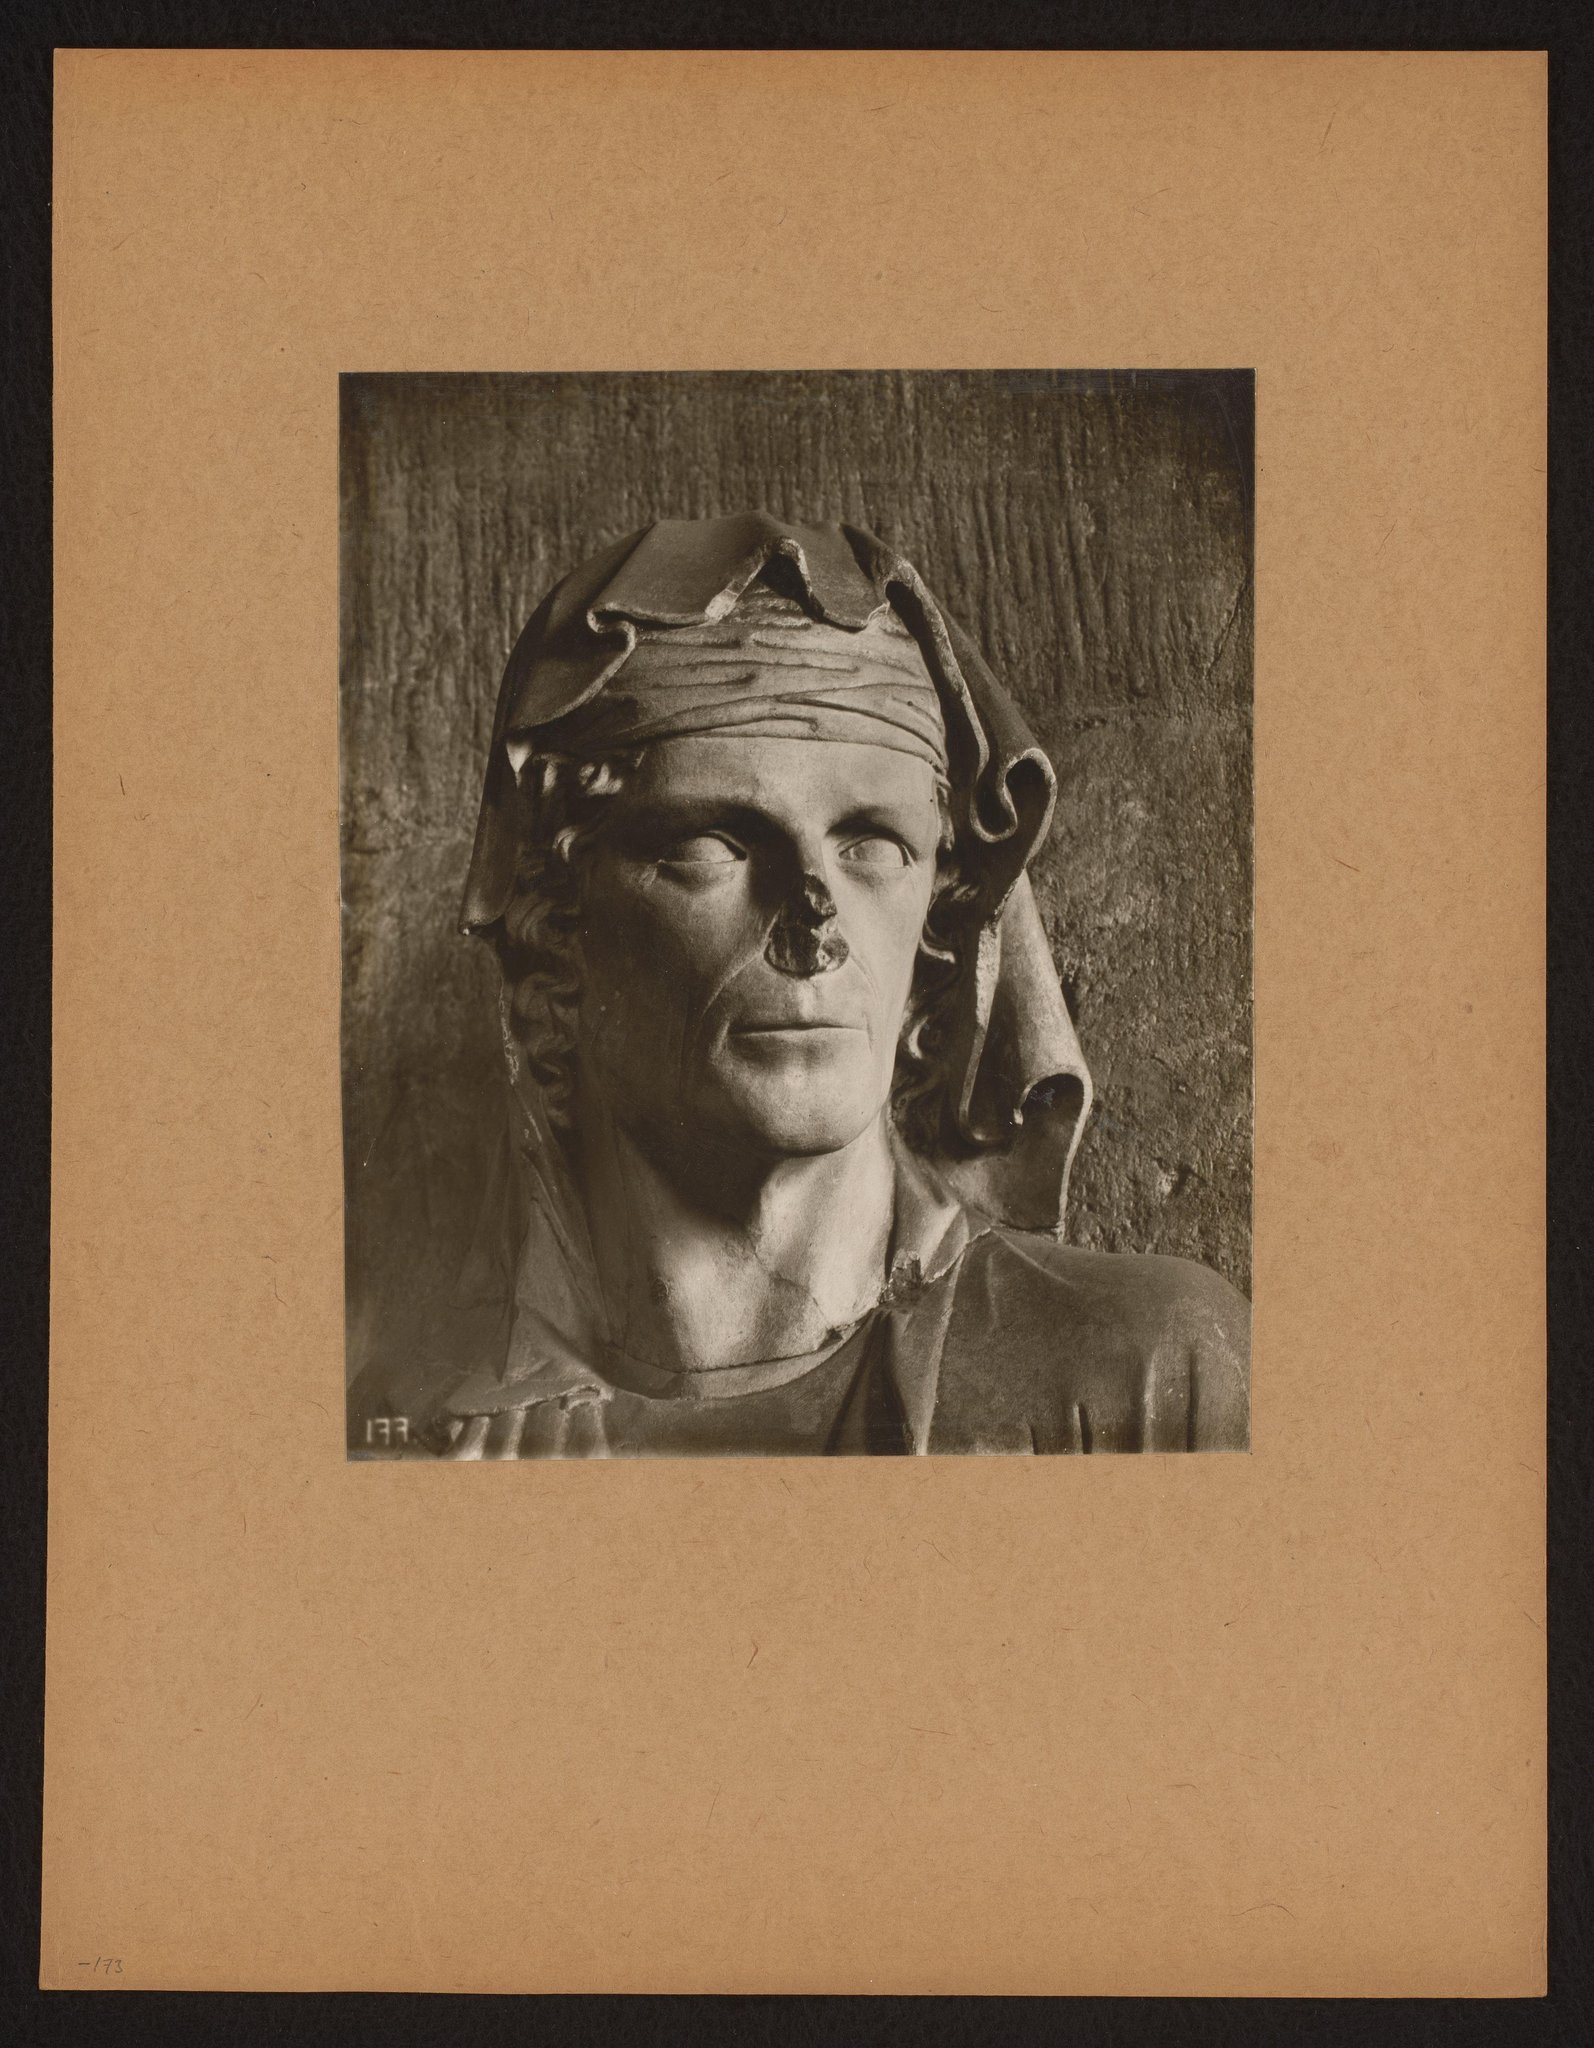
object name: photograph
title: Beeldhouwkunst in de dom van Bamberg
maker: Anonymous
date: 1900-1920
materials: paper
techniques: gelatin silver print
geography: bamberg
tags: church (exterior)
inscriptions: number: ‘177’